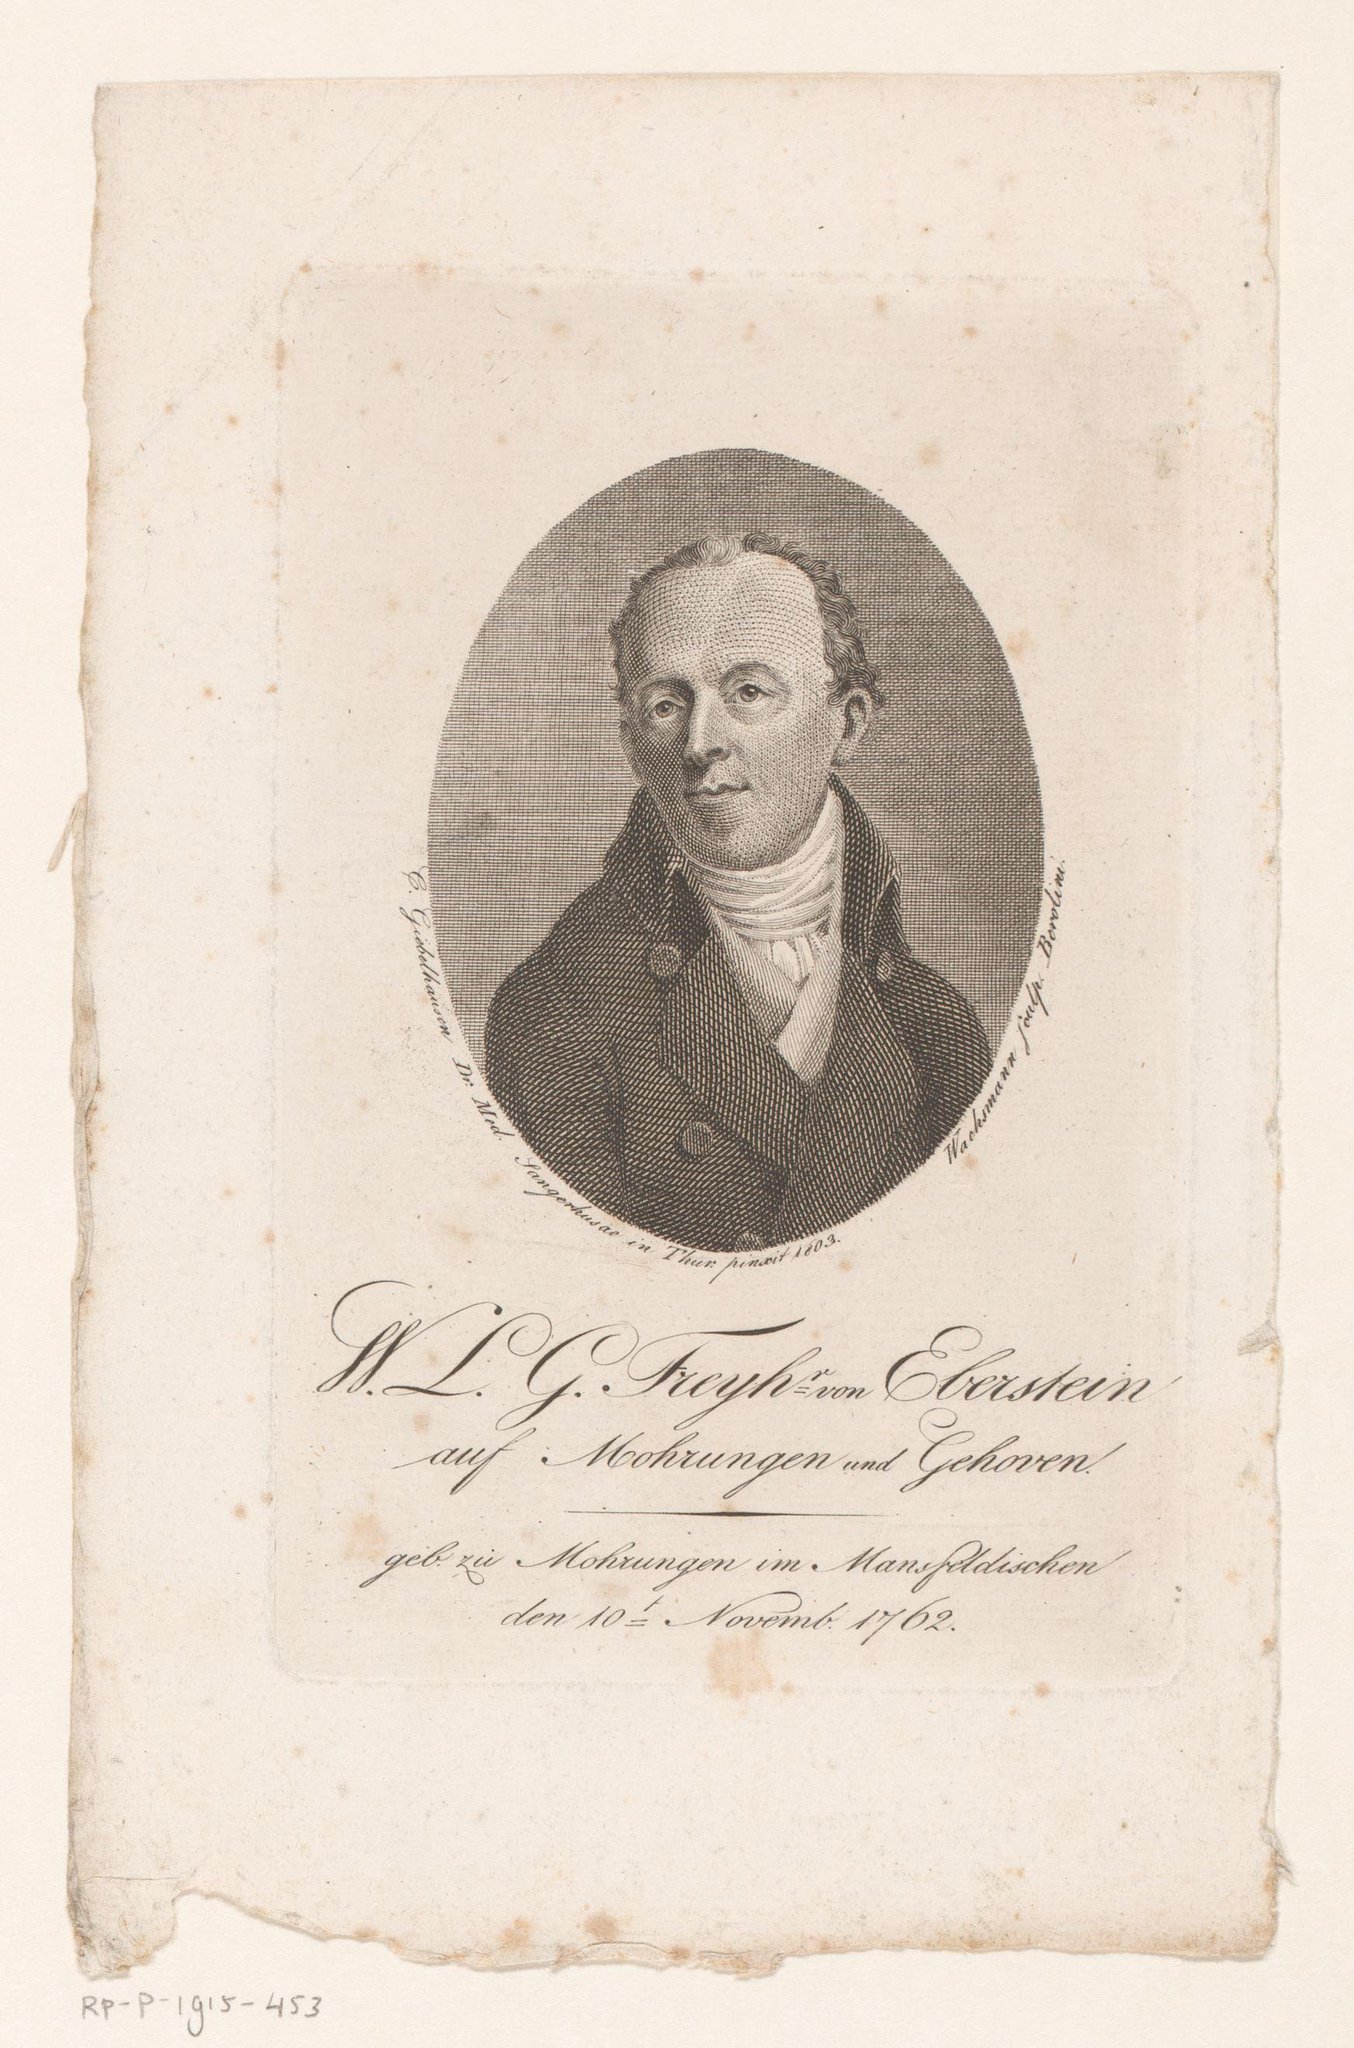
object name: print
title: Portret van Wilhelm Ludwig Gottlob Freiherr von Eberstein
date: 1803-1836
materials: paper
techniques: engraving, etching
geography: berlin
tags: historical persons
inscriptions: collector's mark: Lugt 2228